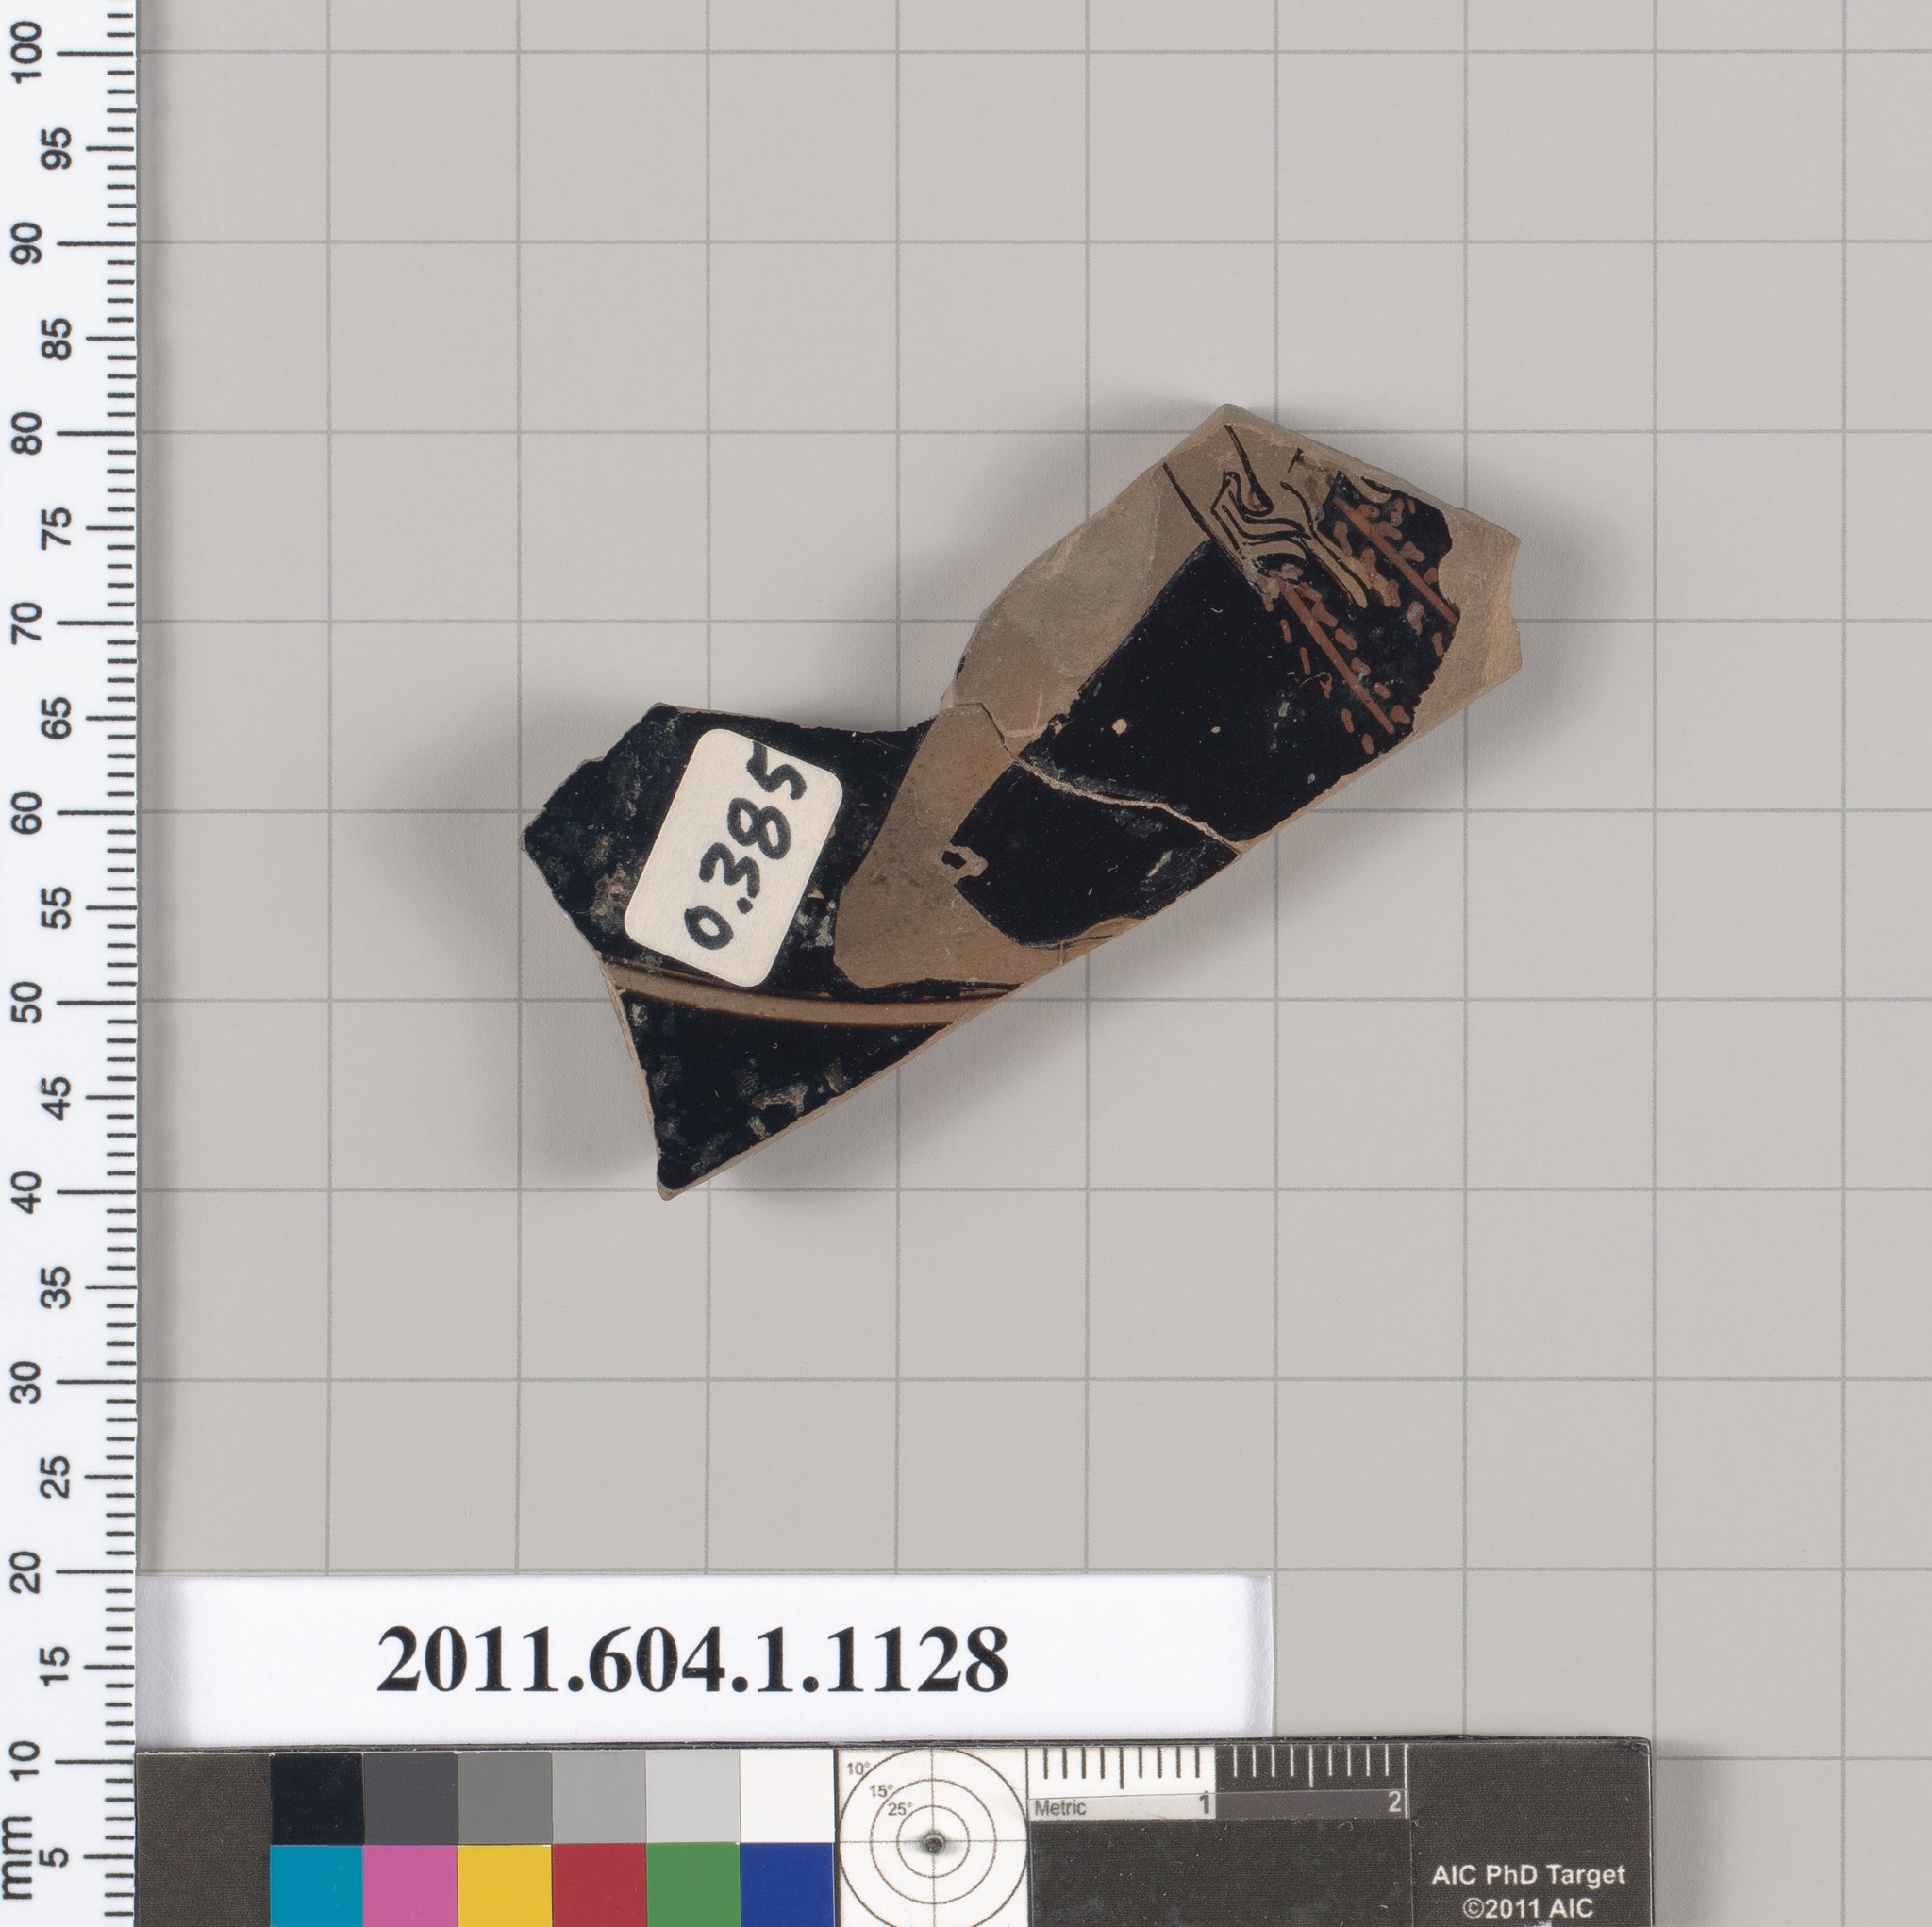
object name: kylix fragment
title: Terracotta fragment of a kylix (drinking cup)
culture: greek, attic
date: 520-500 BCE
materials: terracotta